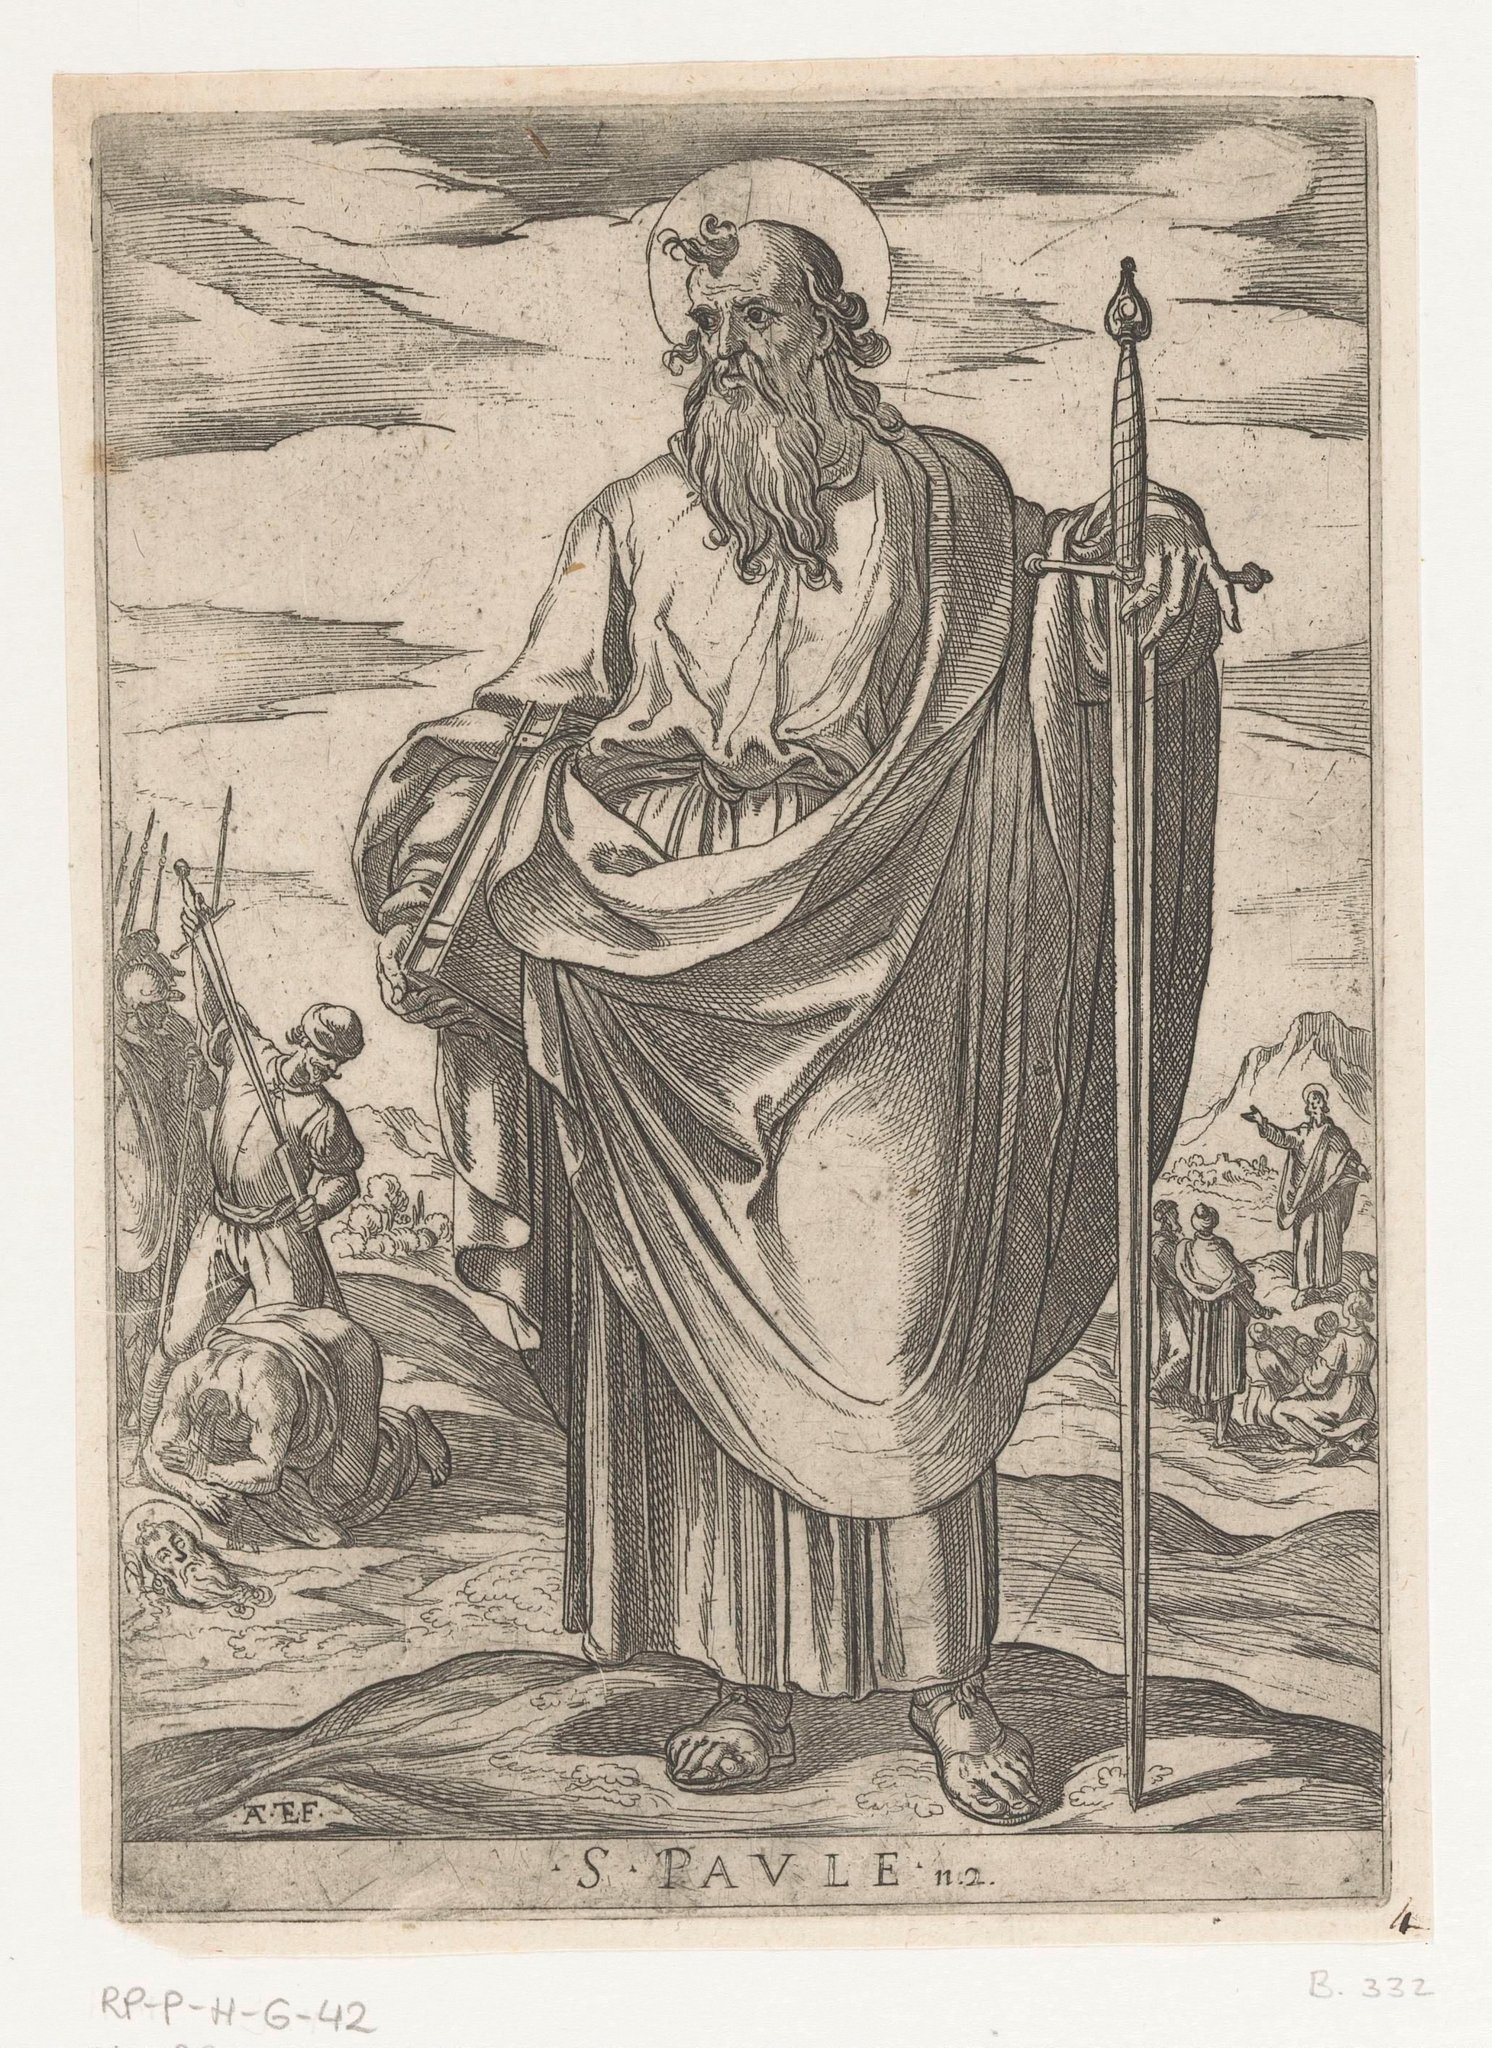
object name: print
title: S. Paule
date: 1565-1630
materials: paper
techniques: etching, intaglio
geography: italy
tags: the beheading of paul; maybe three fountains spring from his head, paul preaching or disputing, the apostle paul of tarsus; possible attributes: book, scroll, sword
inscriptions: collector's mark: ‘Hinloopen’, collector's mark: Lugt 11, number: ‘4’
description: Deze prent maakt deel uit van een reeks van 15 prenten. De prenten met Maria en Christus zijn ongenummerd. De prenten met de apostelen zijn genummerd van 1 tot en met 13.